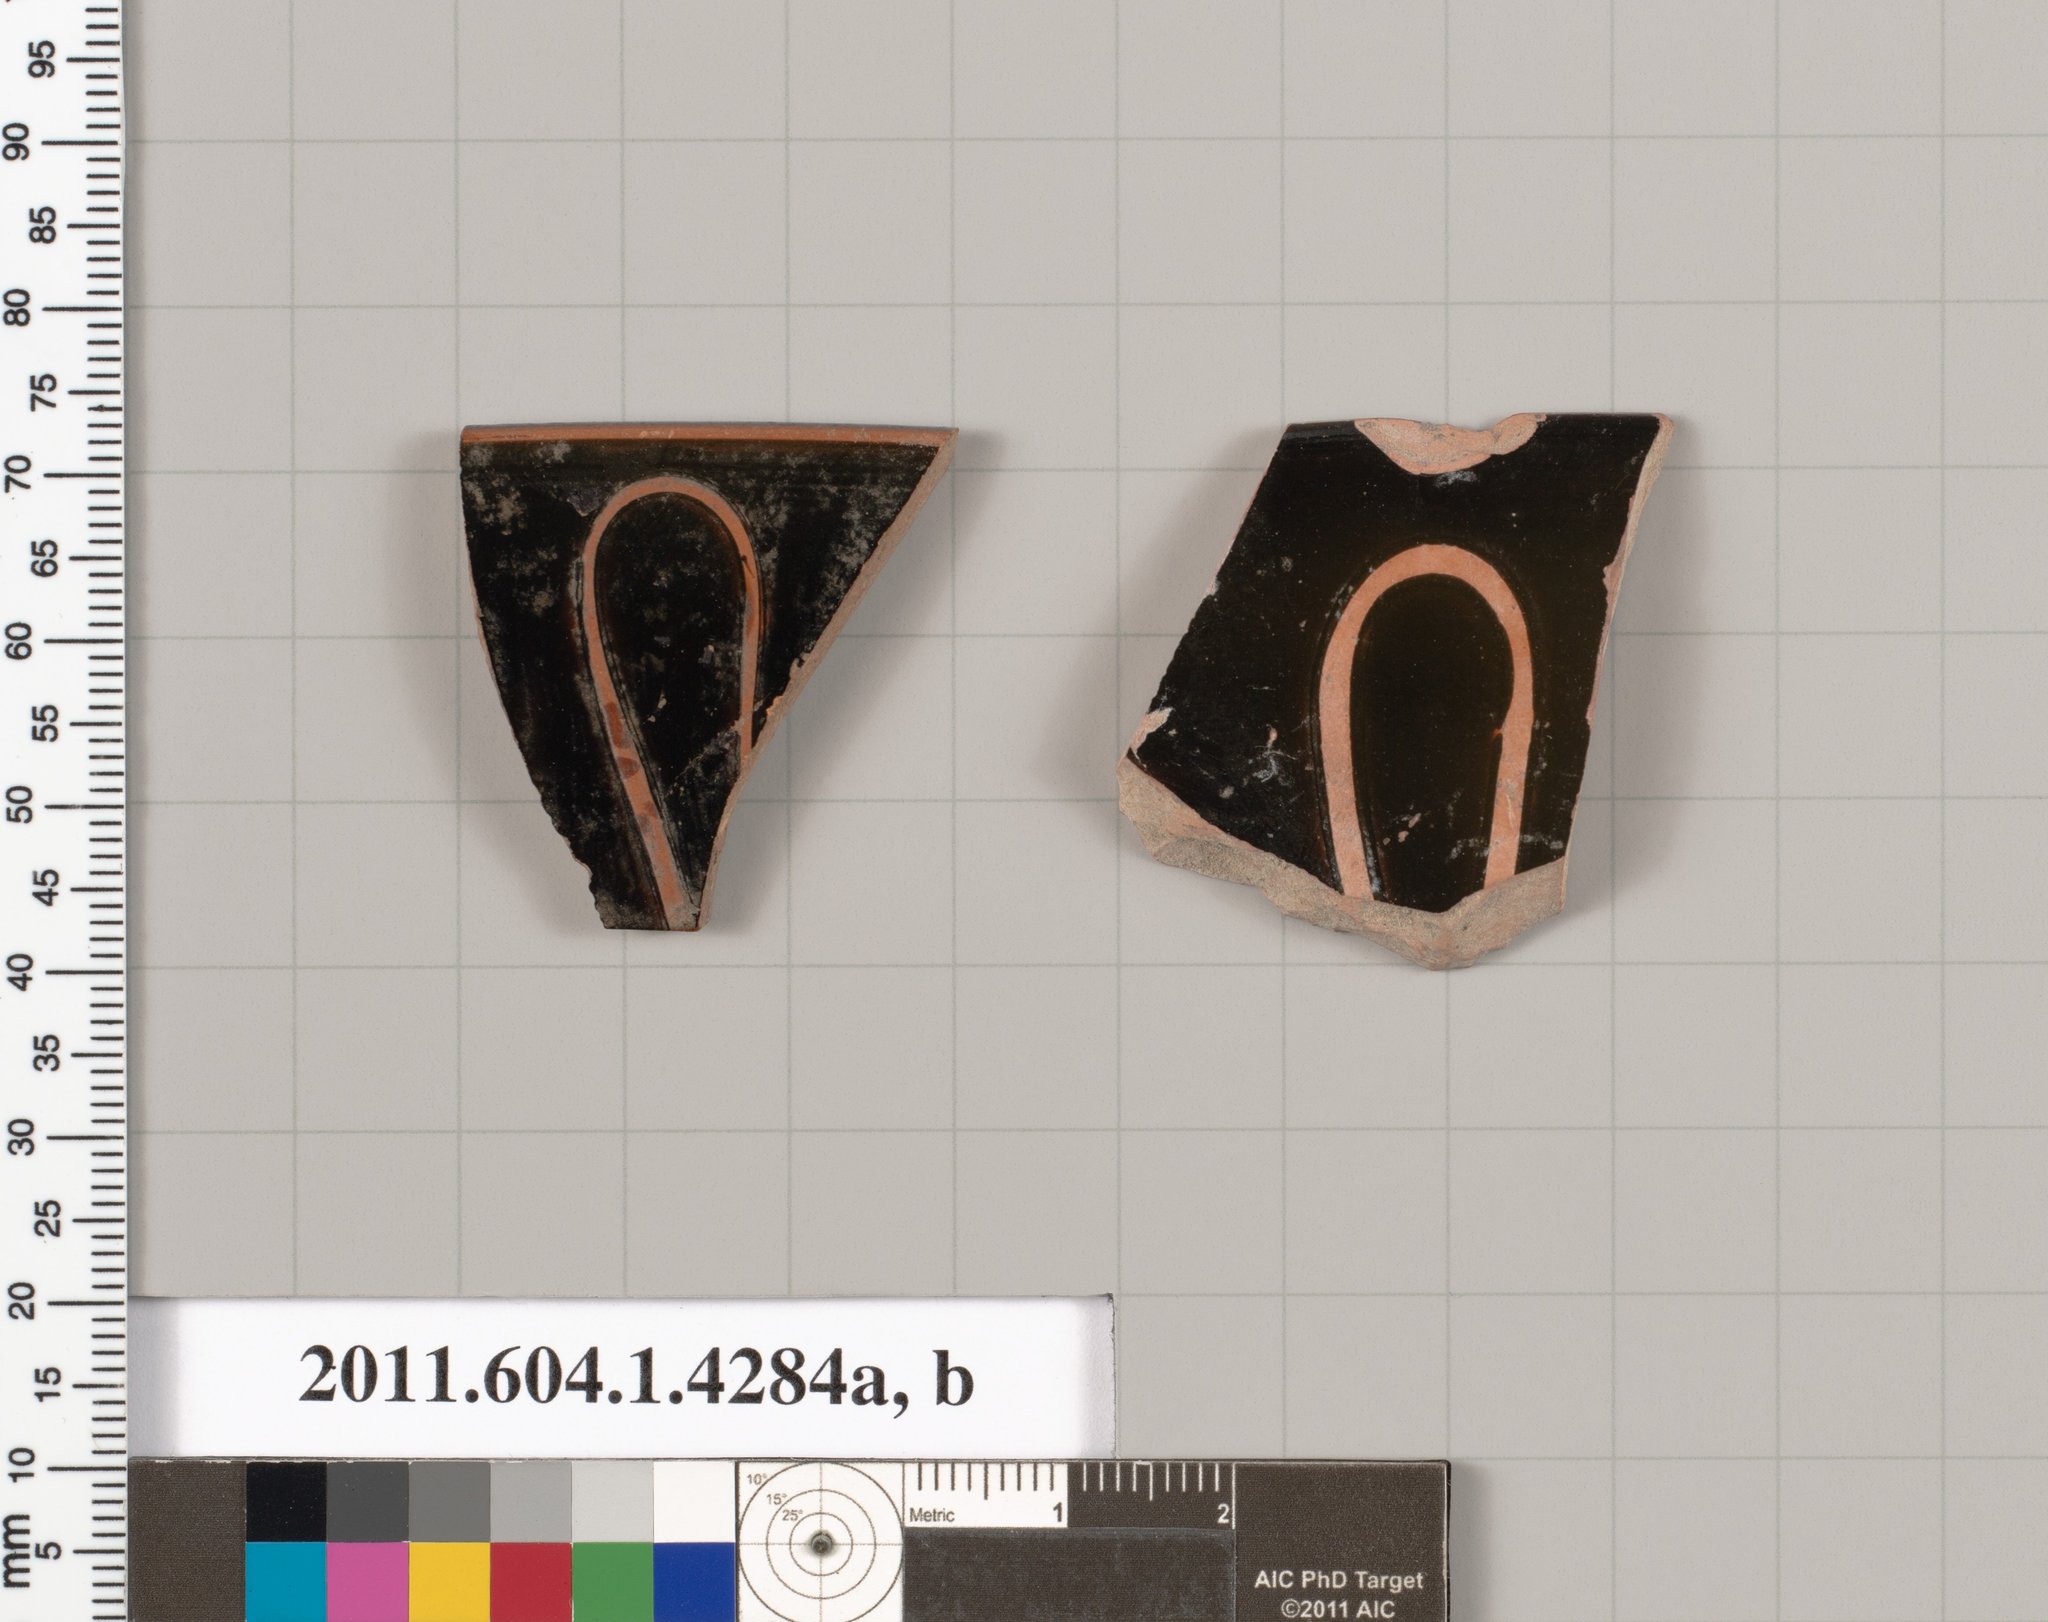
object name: kylix fragment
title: Terracotta rim fragments of kylikes (drinking cups)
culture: greek, attic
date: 500-451 BCE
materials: terracotta